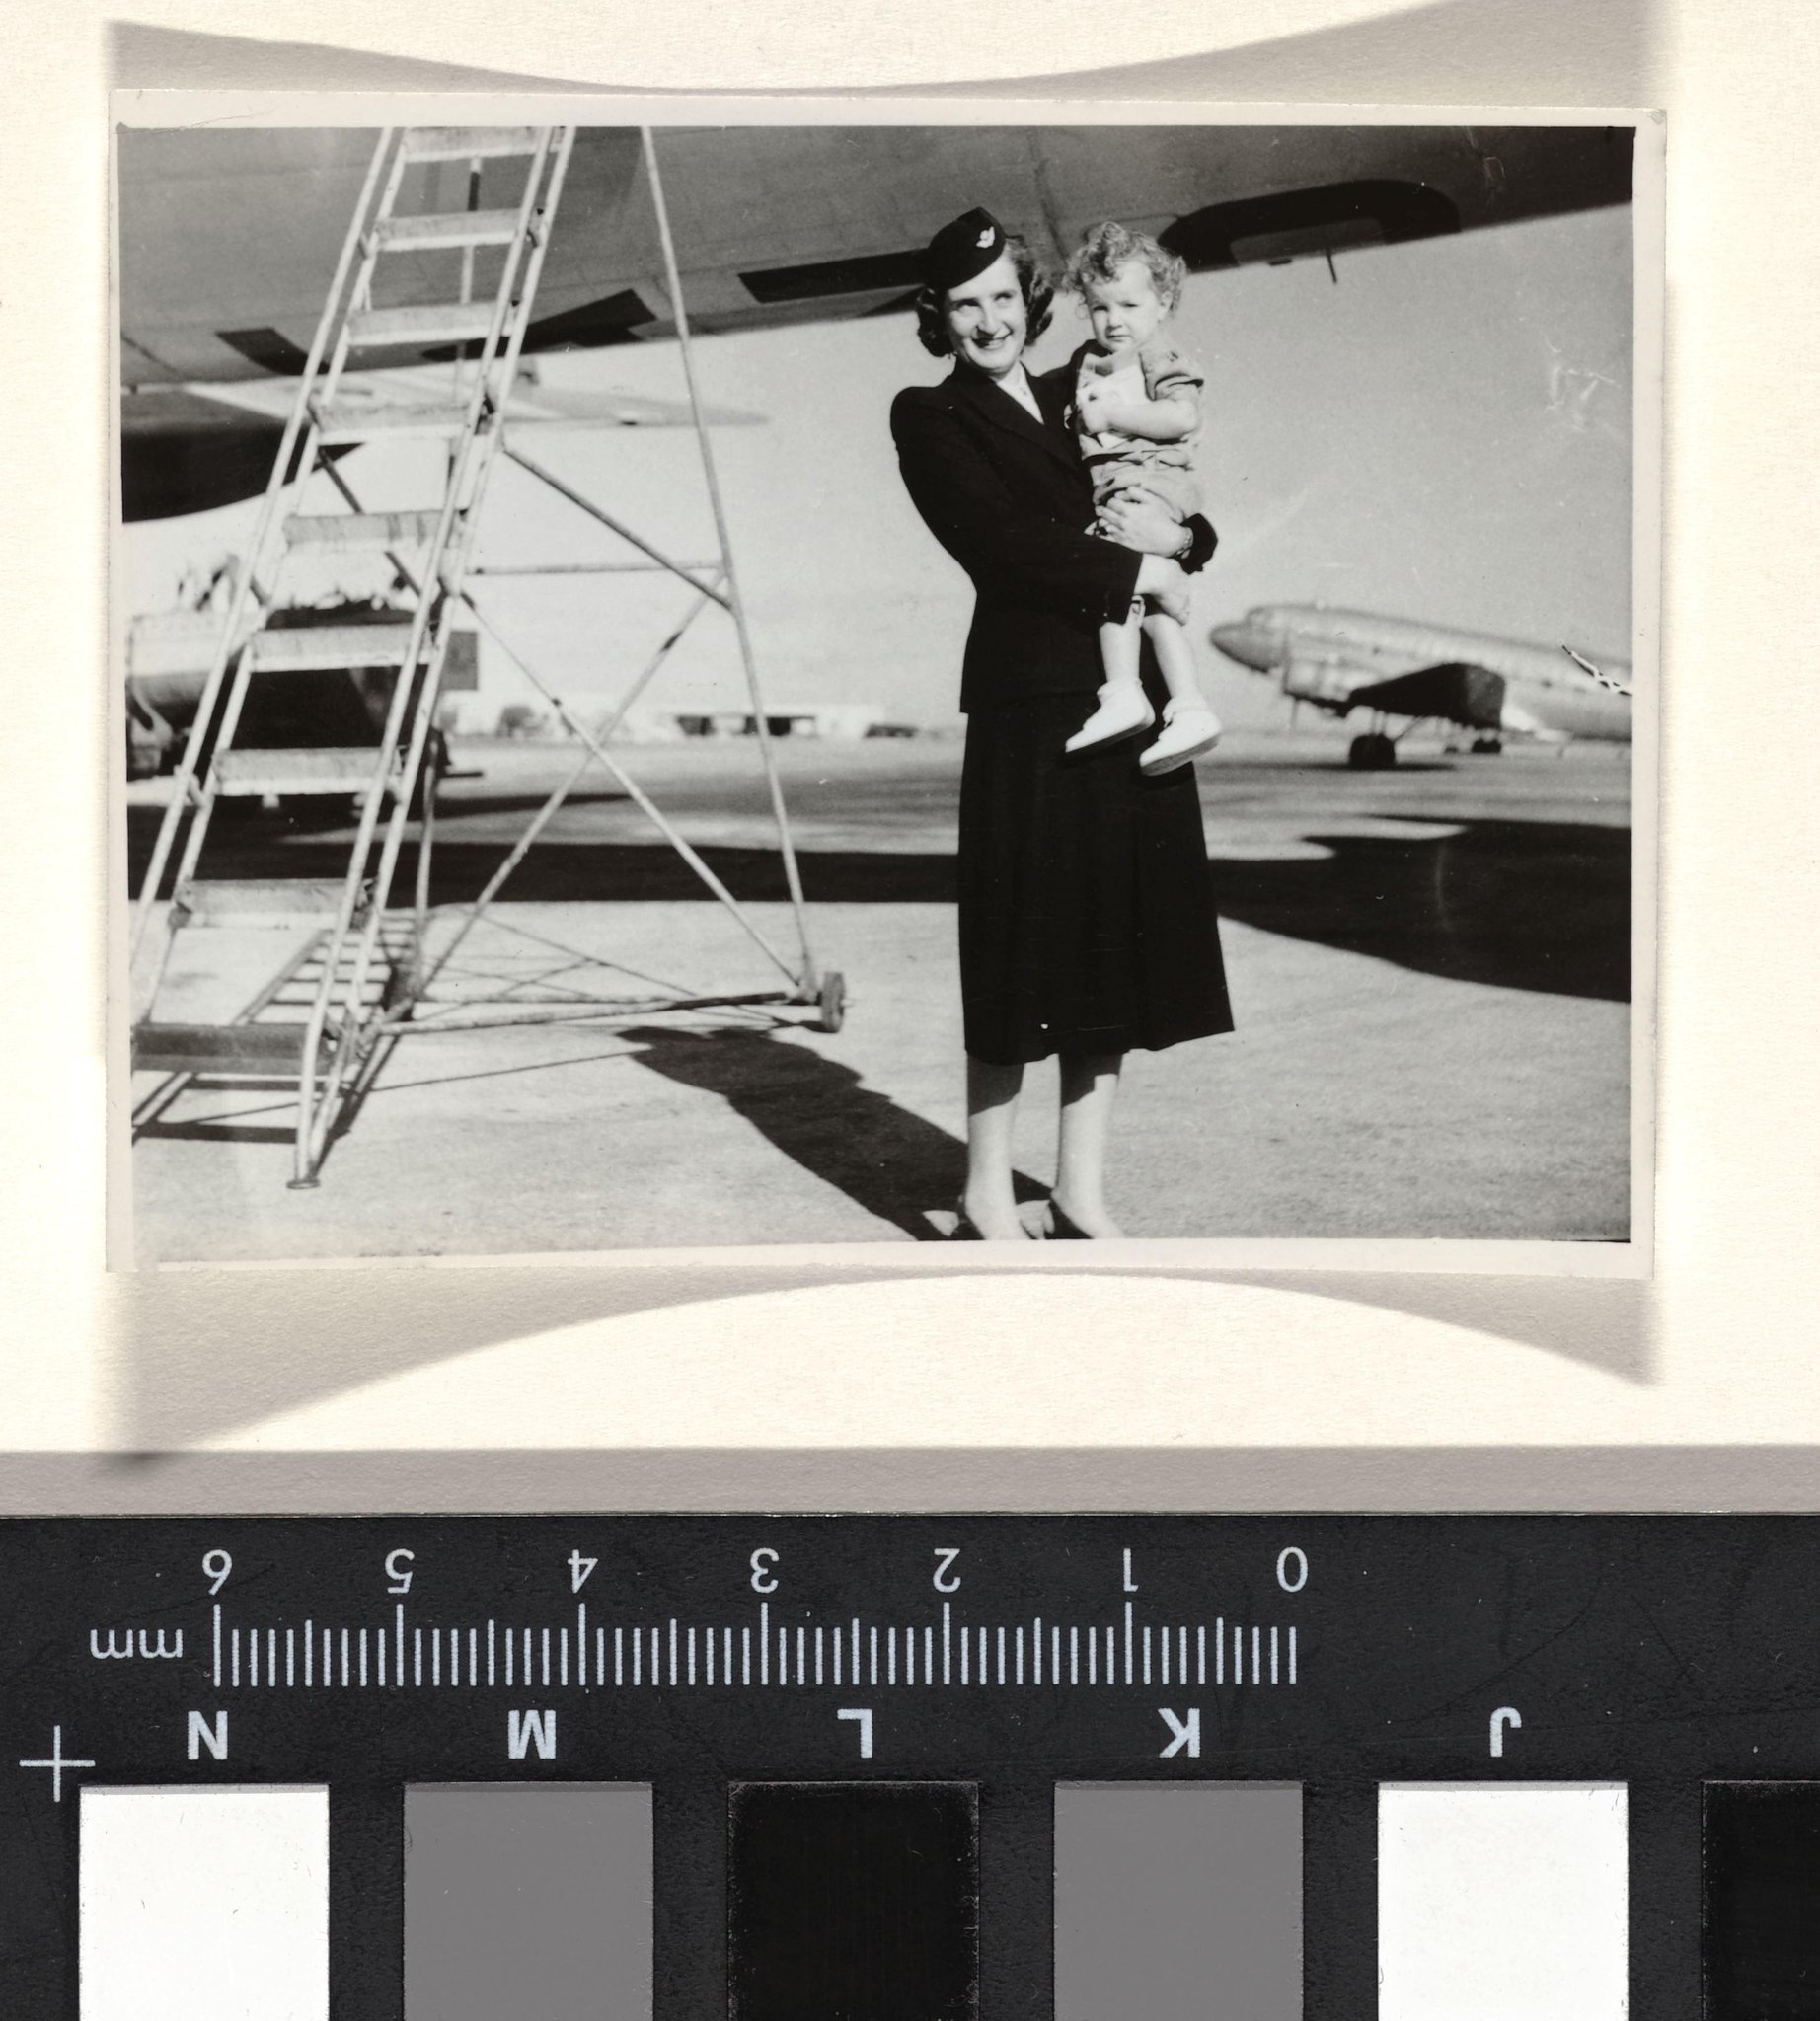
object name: photograph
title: Isabel Wachenheimer in uniform van de KLM met een kind op haar arm, staand voor een KLM-toestel met een trap daar tegenaan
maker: Anonymous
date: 1947-1955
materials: photographic support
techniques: gelatin silver print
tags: leiden, isabel wachenheimer-elon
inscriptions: inscription: ‘Unser Wunsch ist dass auch ihr bald in selben flüch vereint seit, und Dein Lebensglück Du sicher ist. Meinen geliebten Bruder Deine Isabel und Leo ... Andenken an der 24.Nov . 1946.’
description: Isabel Wachenheimer in uniform van de KLM met een kind op haar arm, staand voor een KLM-toestel met een trap daar tegenaan.